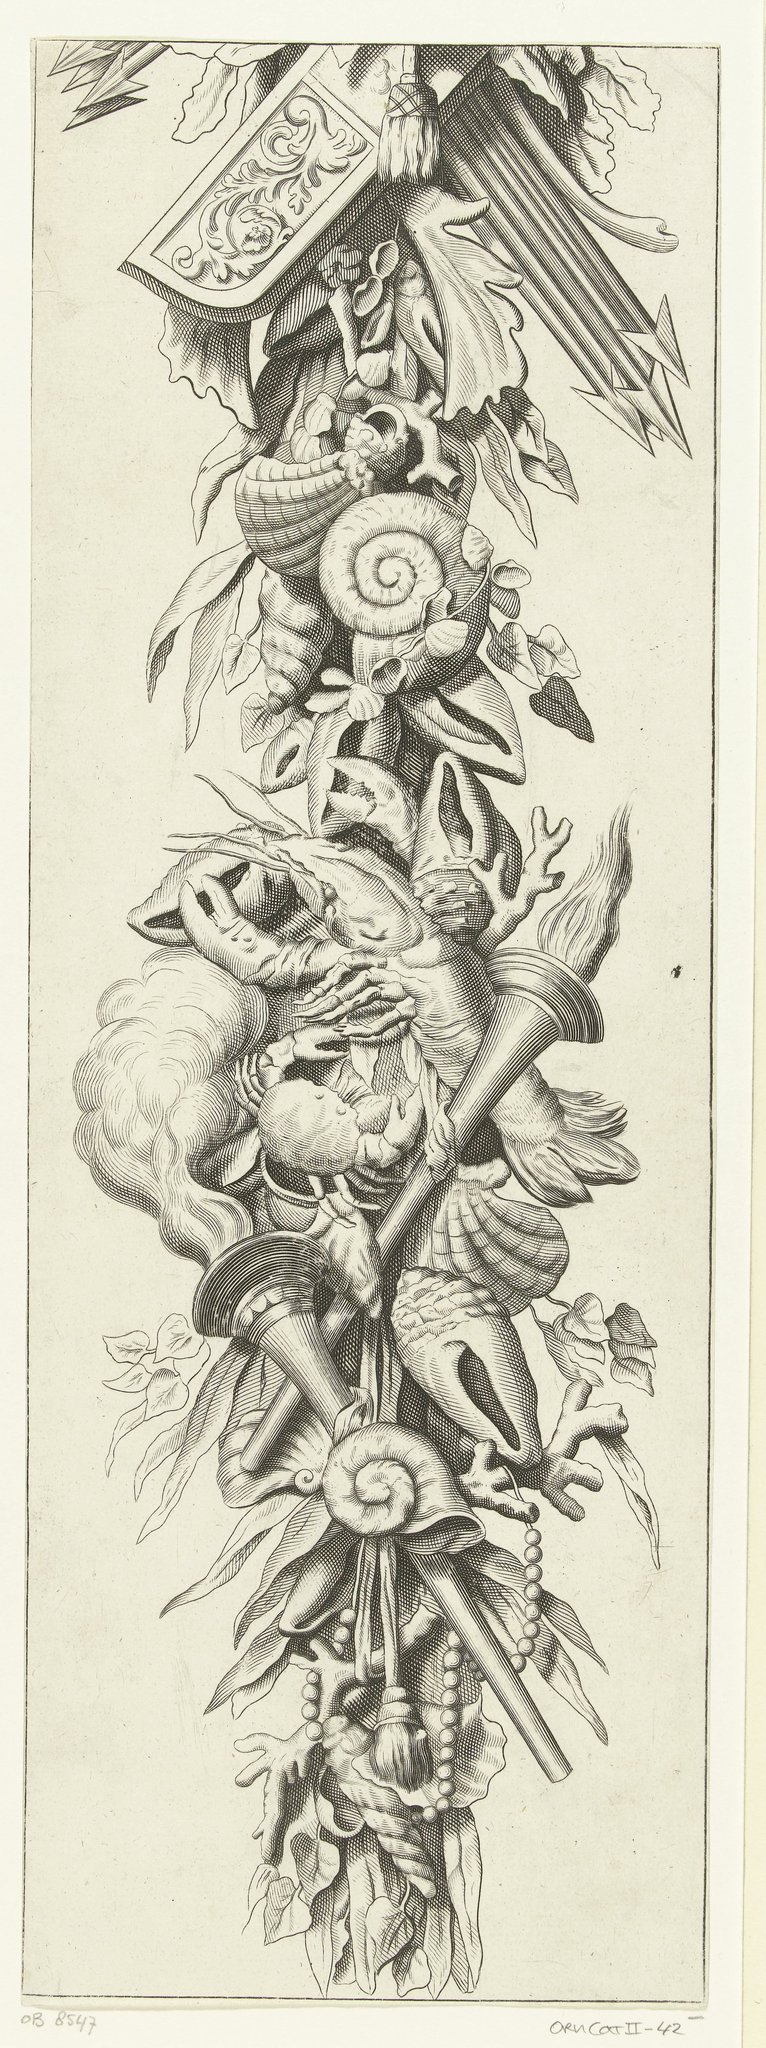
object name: print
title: Trofeeën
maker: Anonymous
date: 1675-1700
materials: paper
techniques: etching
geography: netherlands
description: Onder de pijlkoker hangen schelpen, koraal, een krab, een kreeft, twee fakkels en bladeren. De trofee is hetzelfde als bij objectnummer RP-P-1986-117, maar dan zonder parallel-arcering op de achtergrond.